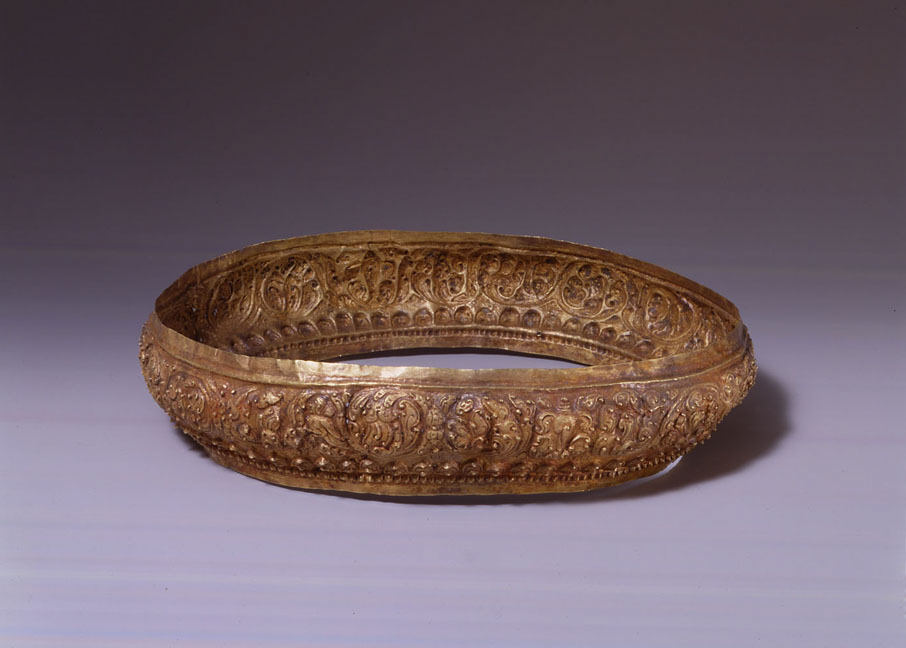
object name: bowl base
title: Base for a Bowl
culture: indonesian, javanese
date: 701-933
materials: gold